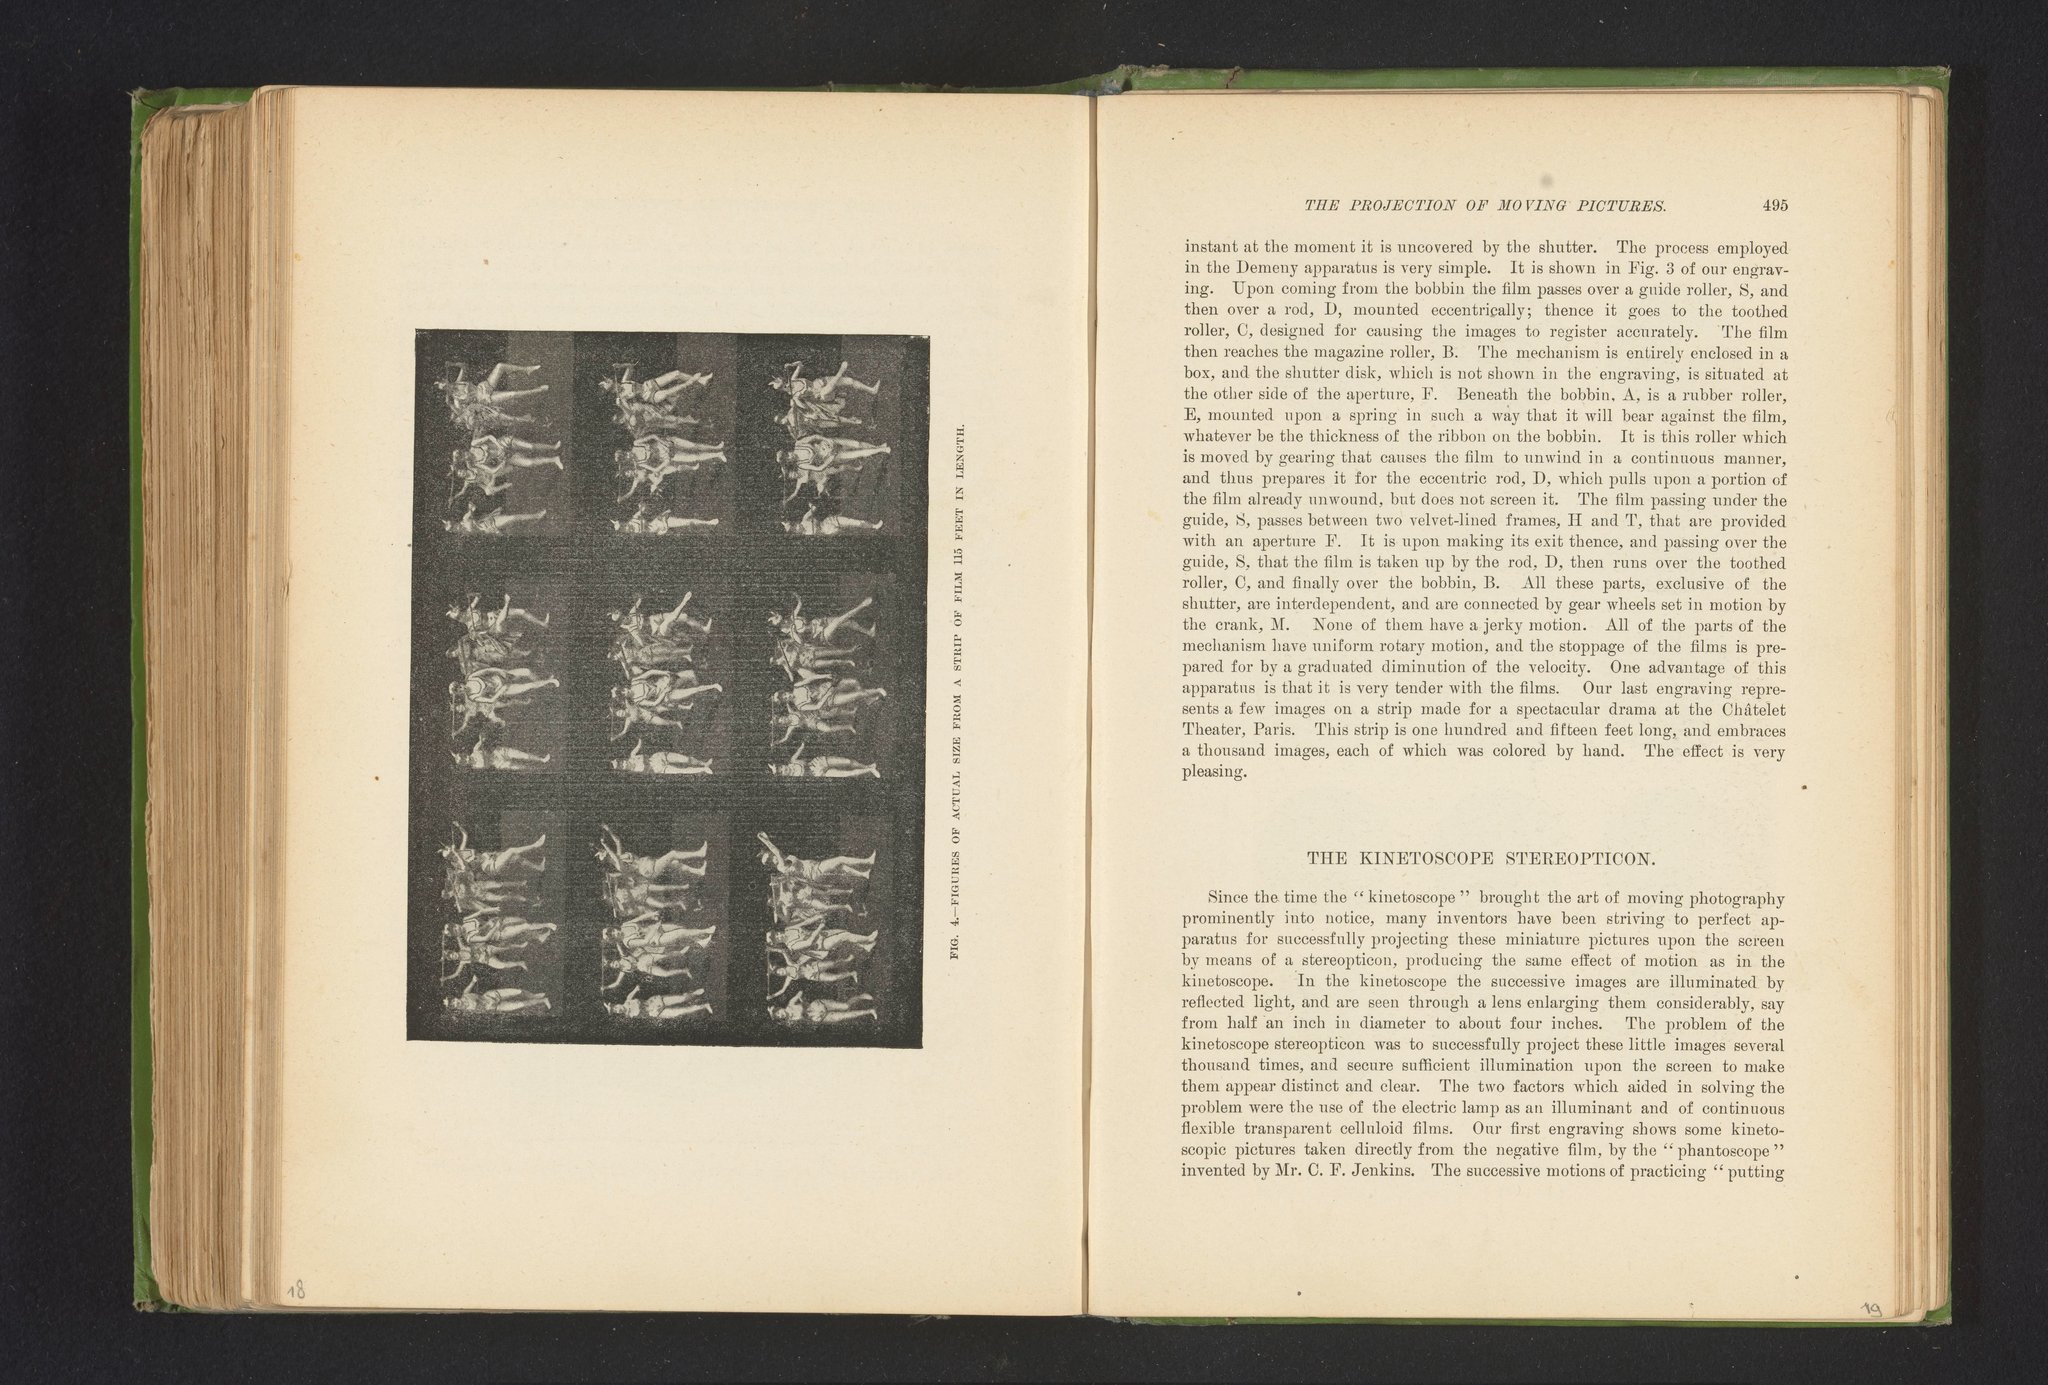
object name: photomechanical print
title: Contactafdruk van drie negatiefstroken, met daarop danseressen afgebeeld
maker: Anonymous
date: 1892-1897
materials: paper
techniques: autotype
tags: negative ~ photography, ballet group; dancers on the stage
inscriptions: inscription: ‘Fig. 4. - Figures of Actual Size from a Strip of Film 115 Feet in Length’